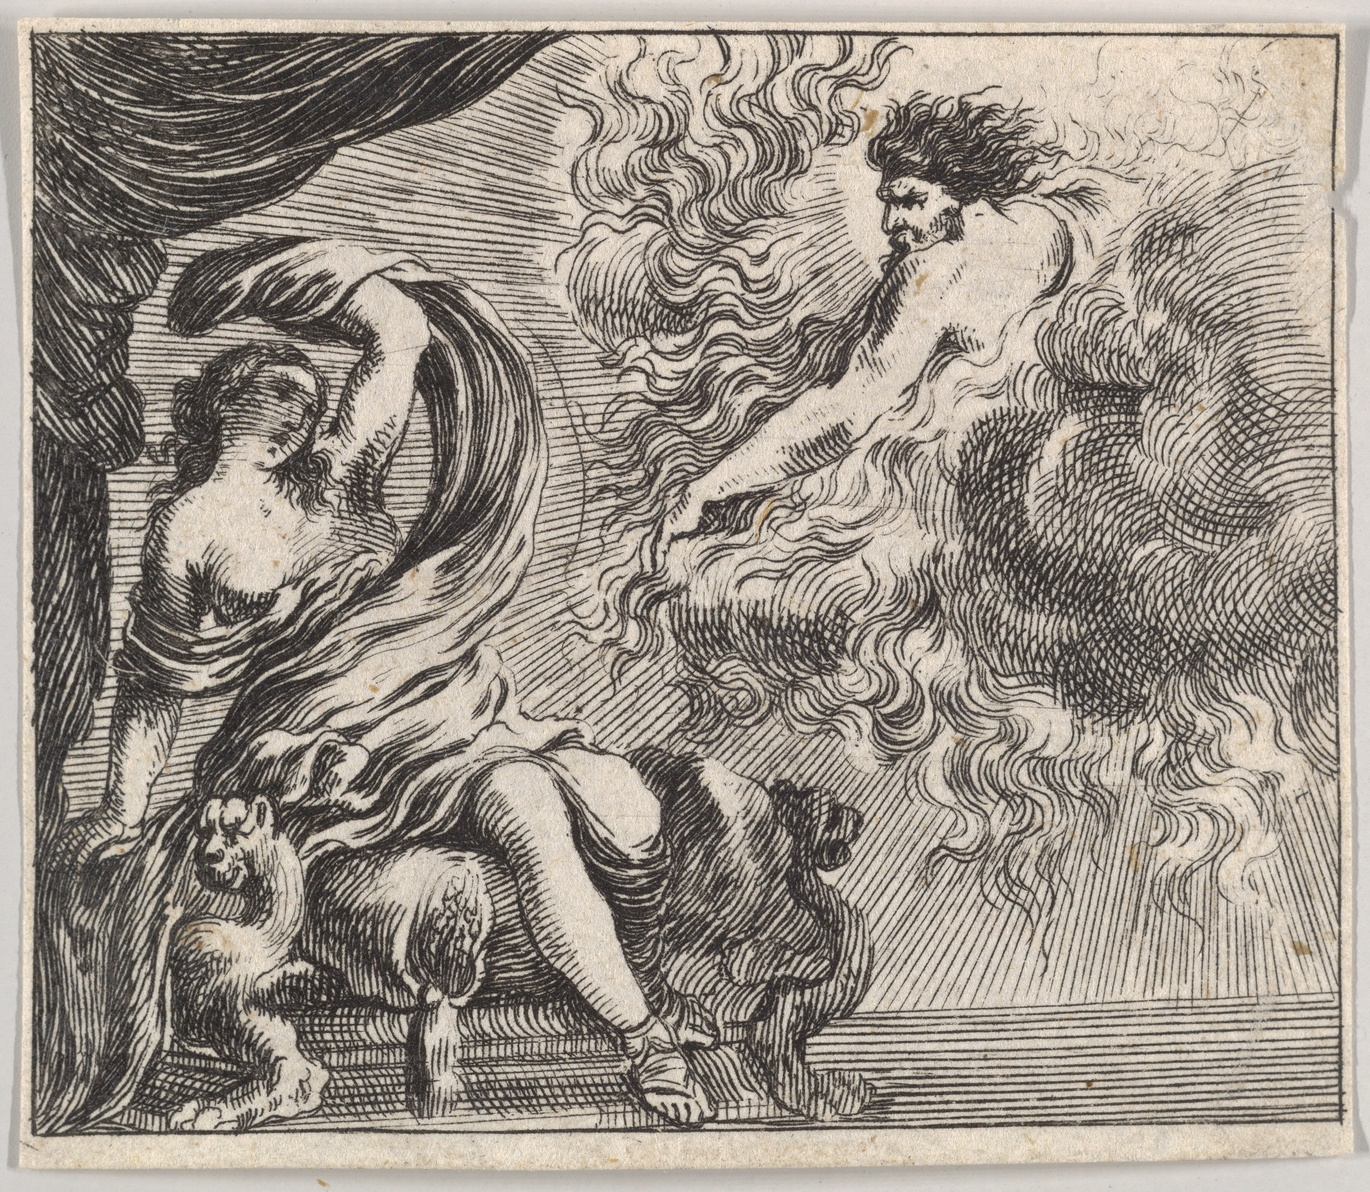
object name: print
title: Jupiter and Semele, from "Game of Mythology" (Jeu de la Mythologie)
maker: stefano della bella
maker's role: artist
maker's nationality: italian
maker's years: 1610-1664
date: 1644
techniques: etching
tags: women,jupiter